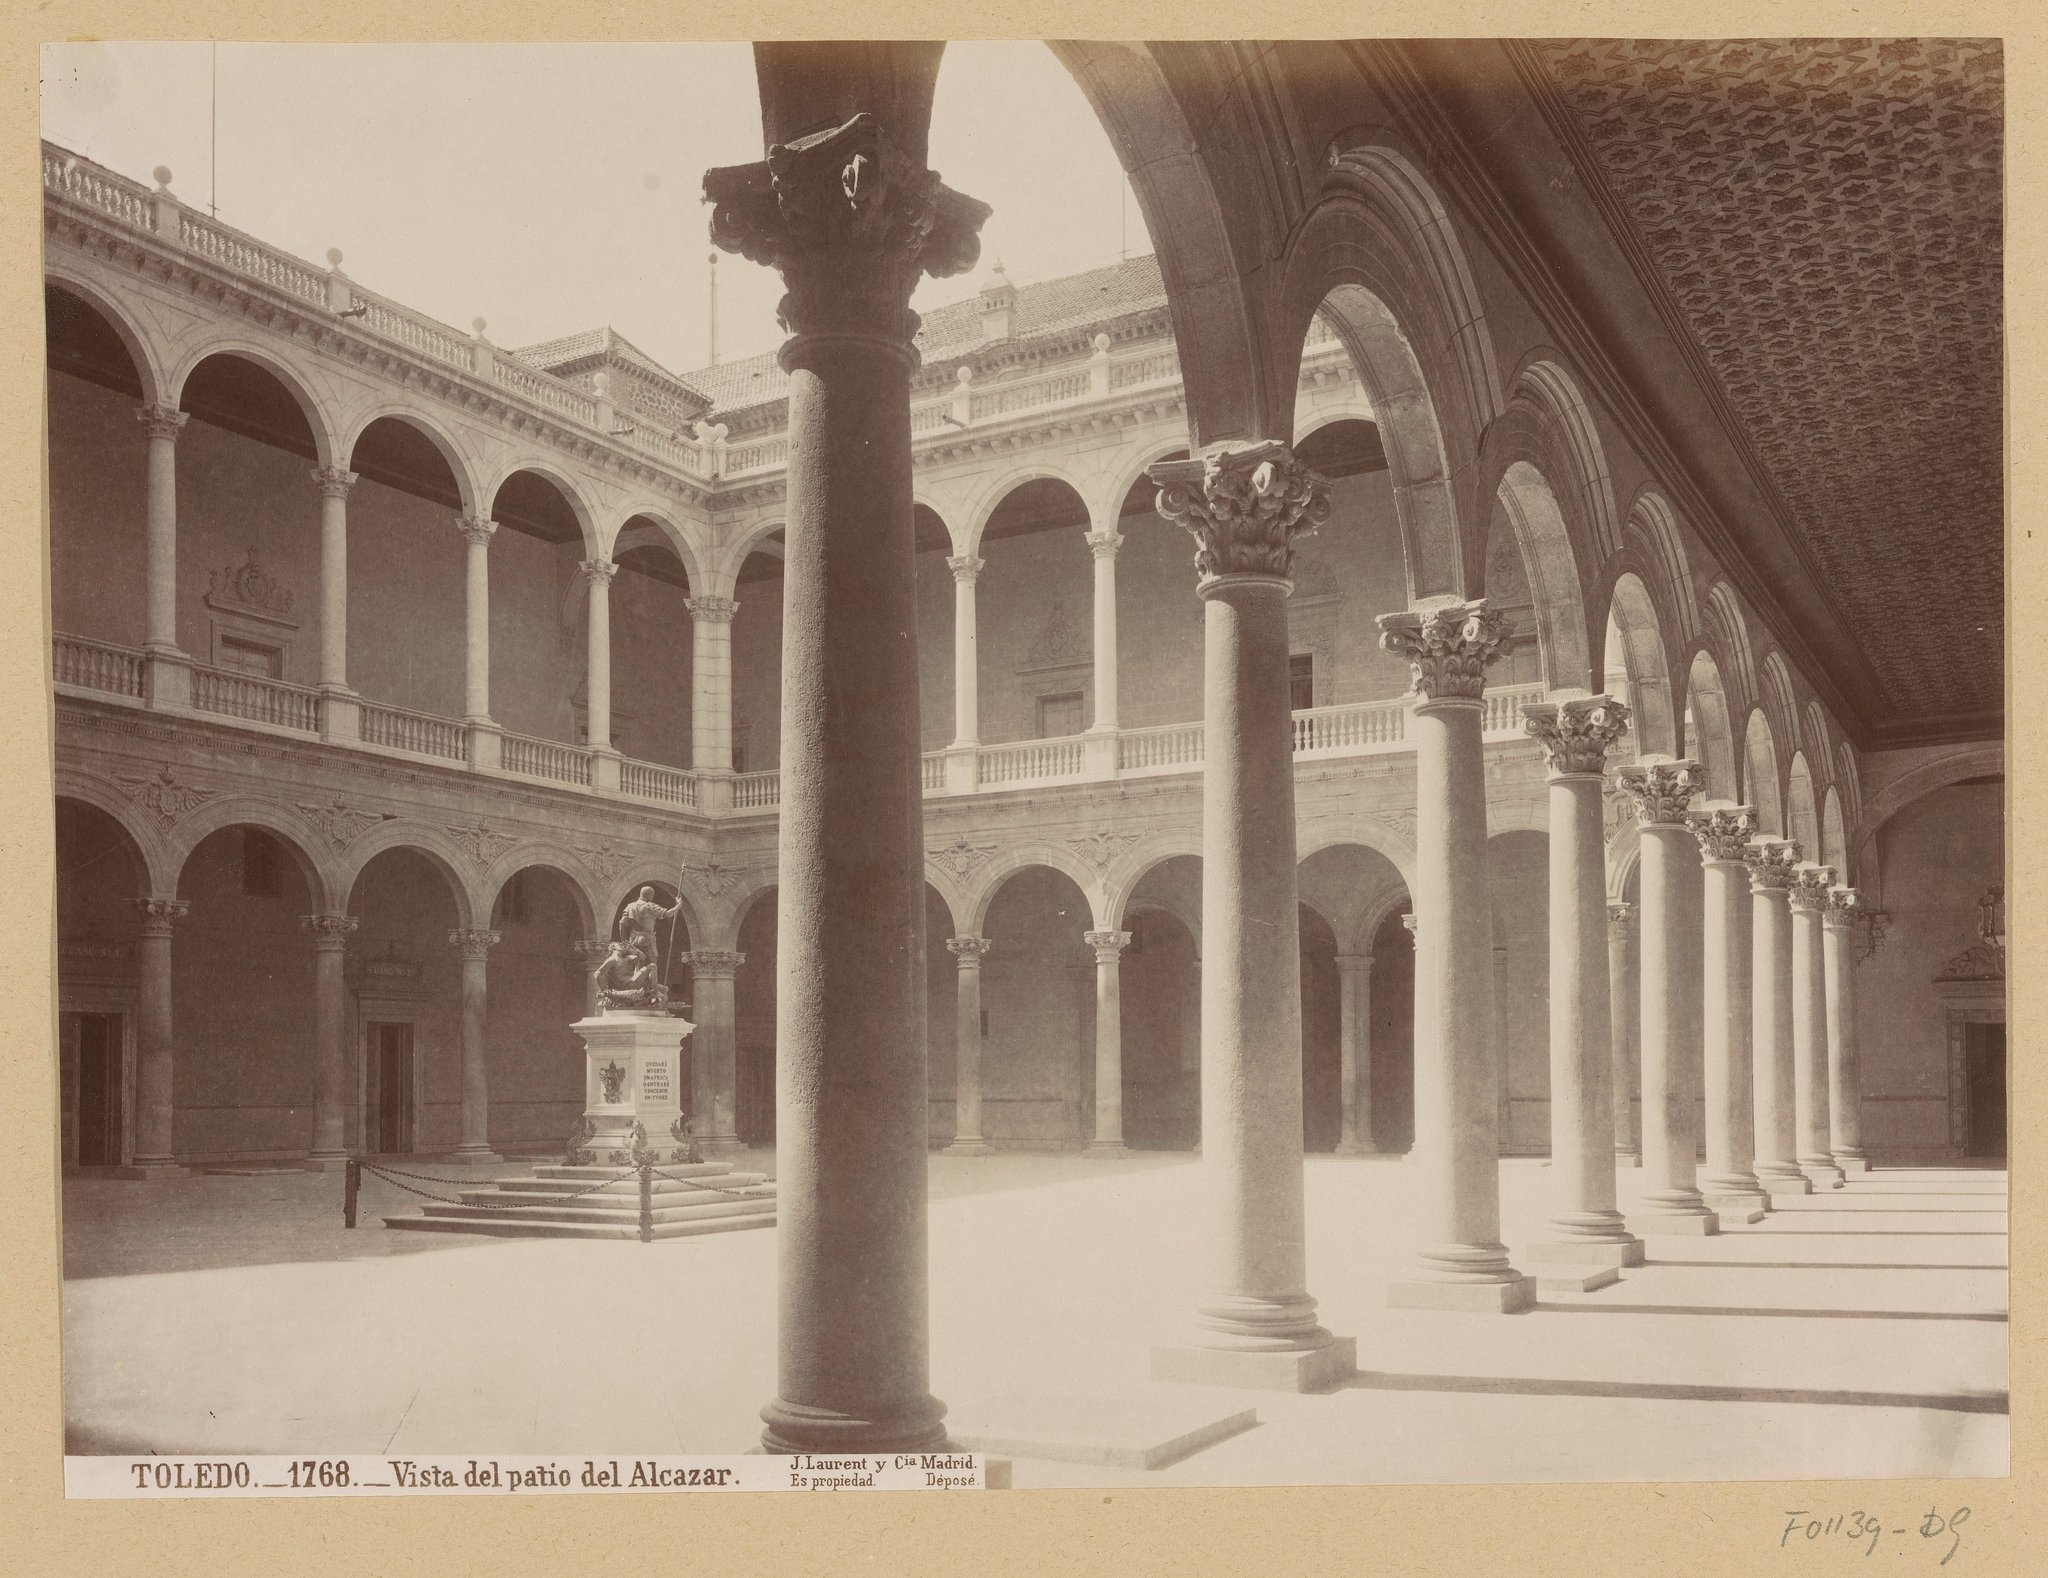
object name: photograph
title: Toledo, vista del patio del Alcazar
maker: juan laurent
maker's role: publisher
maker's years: 1816-1896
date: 1863-1883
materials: paper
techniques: albumen print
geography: toledo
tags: courtyard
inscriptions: inscription: ‘Es propiedad./ Déposé.’, number: ‘1768.’